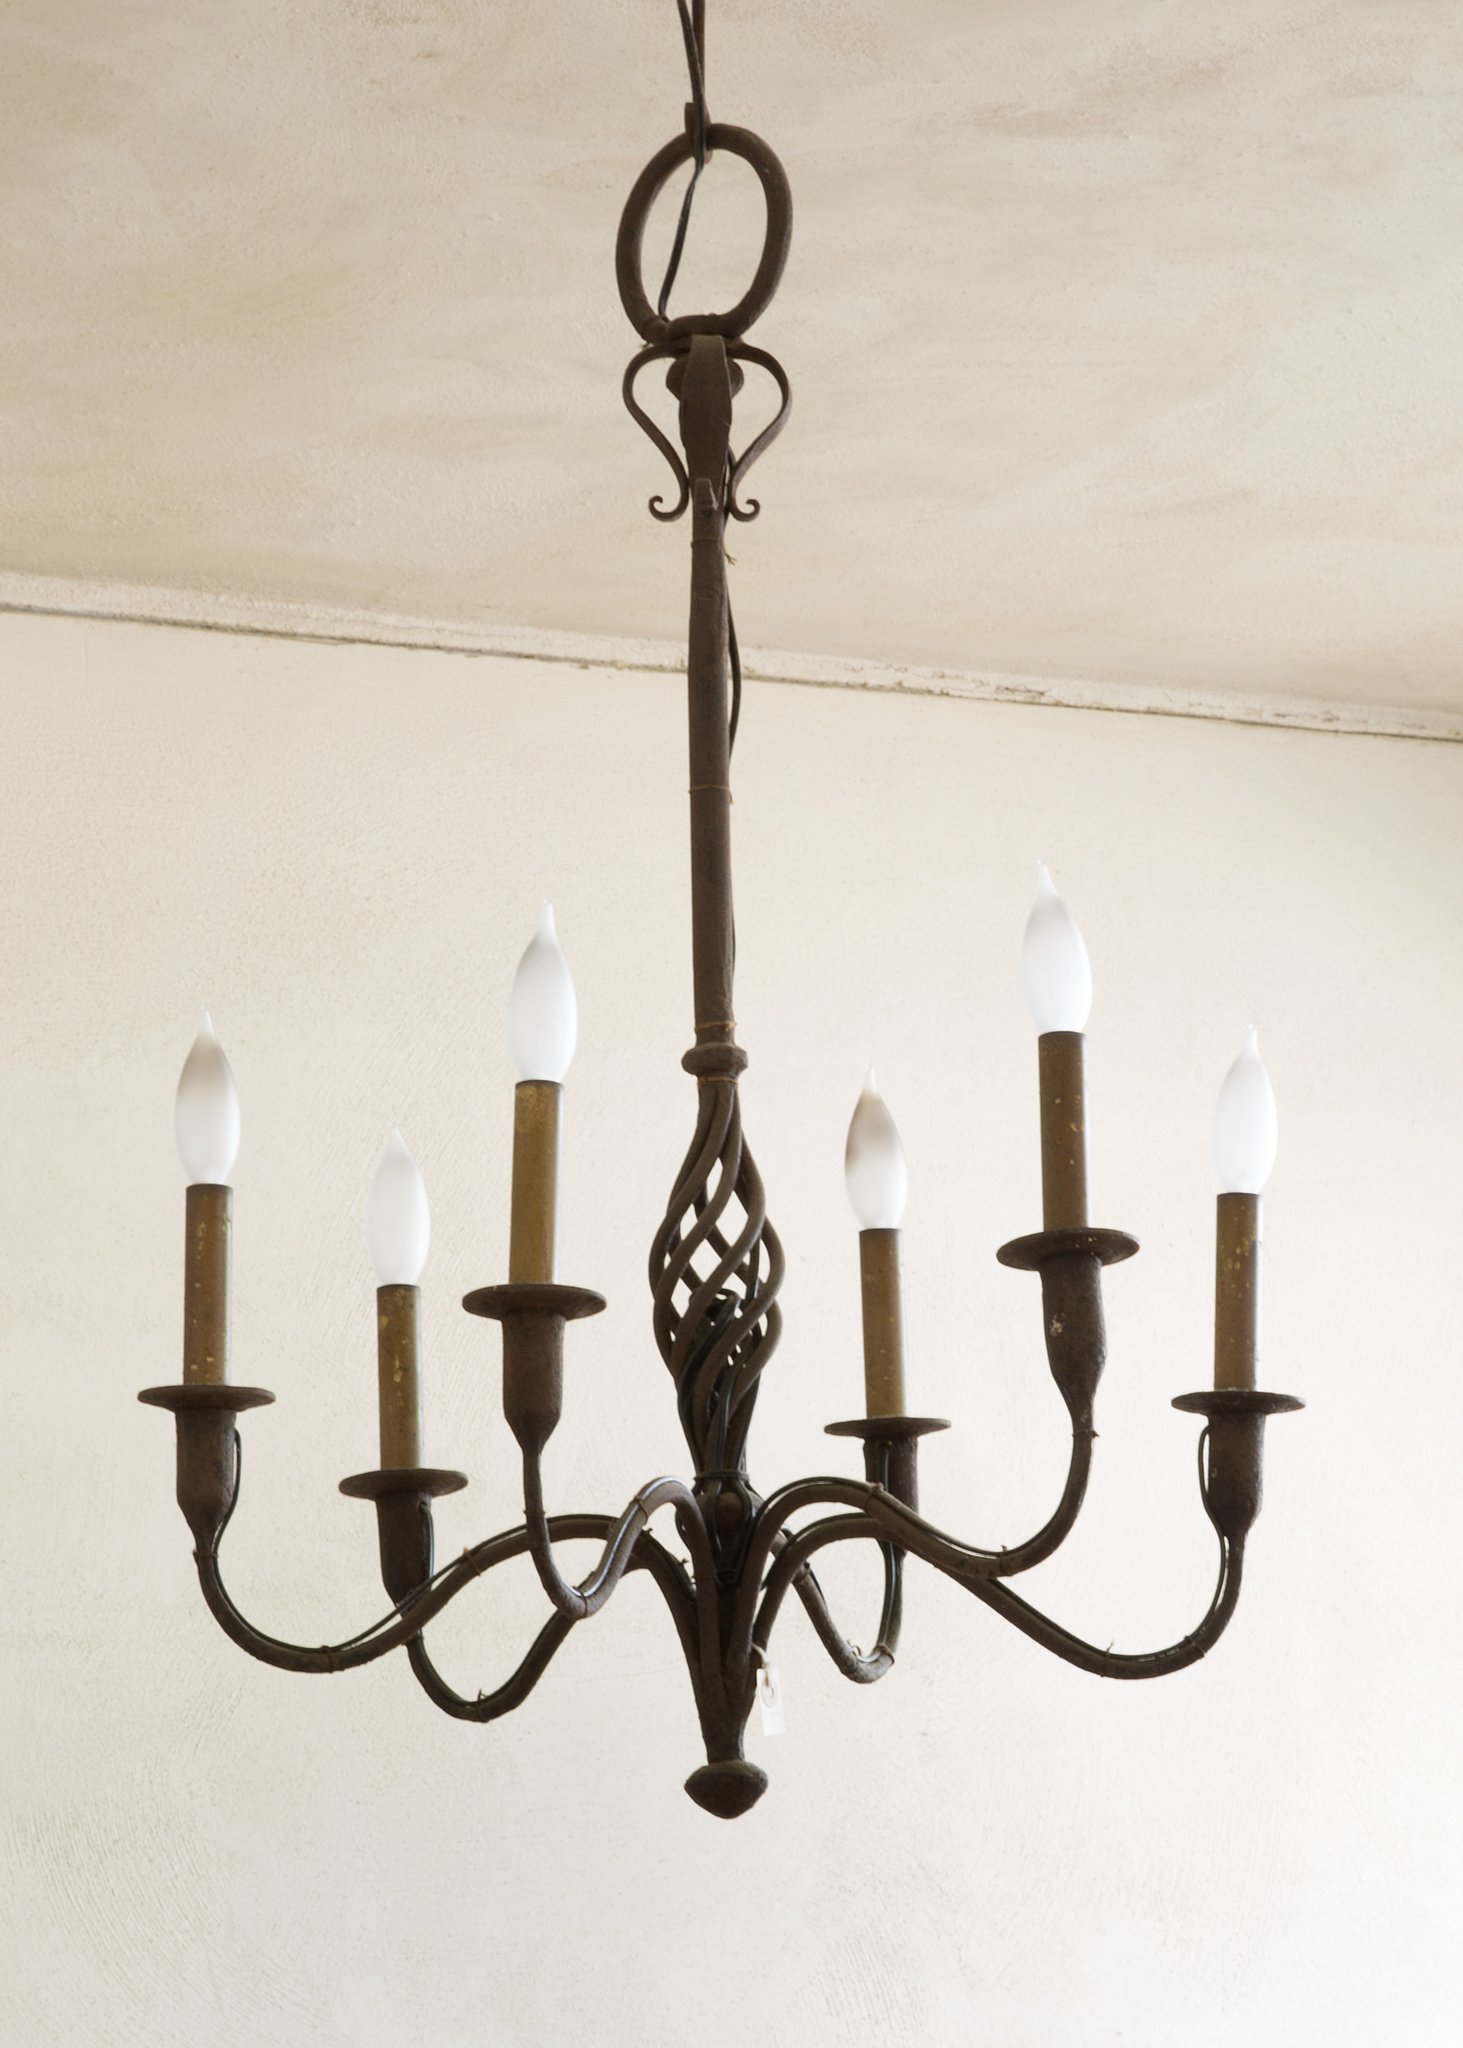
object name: chandelier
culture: french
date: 1500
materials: iron